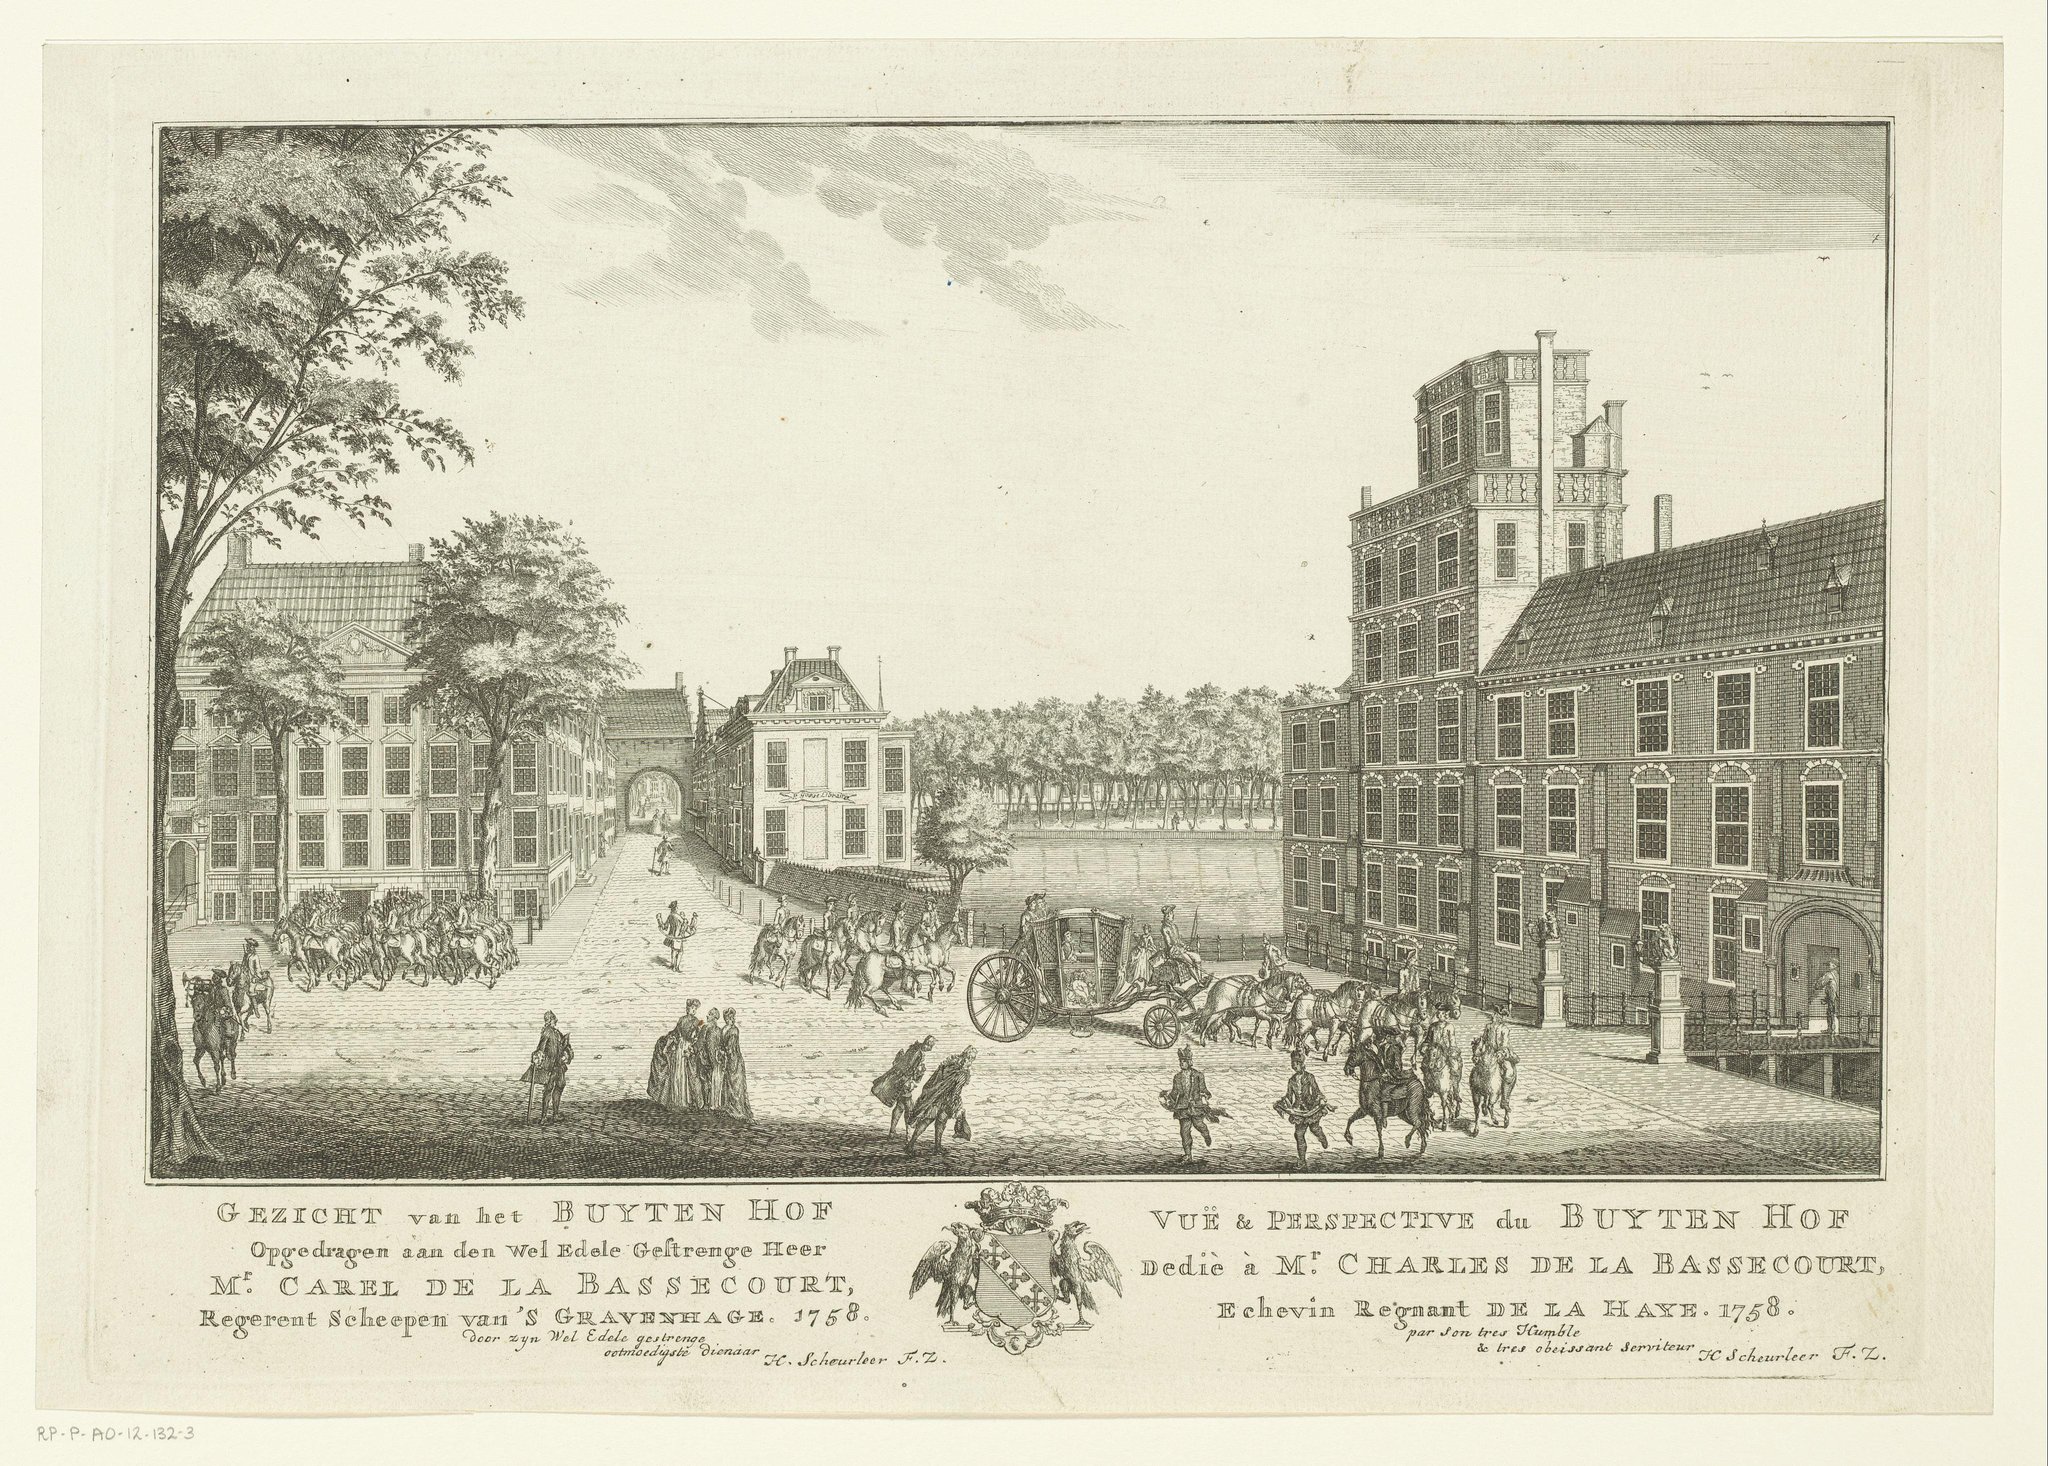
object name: print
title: Gezicht van het Buyten Hof / Vuë & perspective du Buyten Hof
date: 1758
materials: paper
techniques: engraving, etching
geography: the hague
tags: pond, pool, square, place, circus, etc. (+ city(-scape) with figures, staffage), armorial bearing, heraldry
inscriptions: collector's mark: Lugt 2228, collector's mark: Lugt 195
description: Gezicht op het Buitenhof te Den Haag, gezien in de richting van de Gevangenpoort. Links het Vijverhof of Noyelleshuis met rechts daarvan de Gevangenpoort. In het midden de Hofvijver met daarachter de Lange Vijverberg. Rechts het Stadhouderlijk Kwartier. Onder de voorstelling de titel en opdracht in het Nederlands en Frans, met in het midden het familiewapen van de Haagse schepen Carel de la Bassecour. Prent uit een serie van achttien gezichten in en om Den Haag.